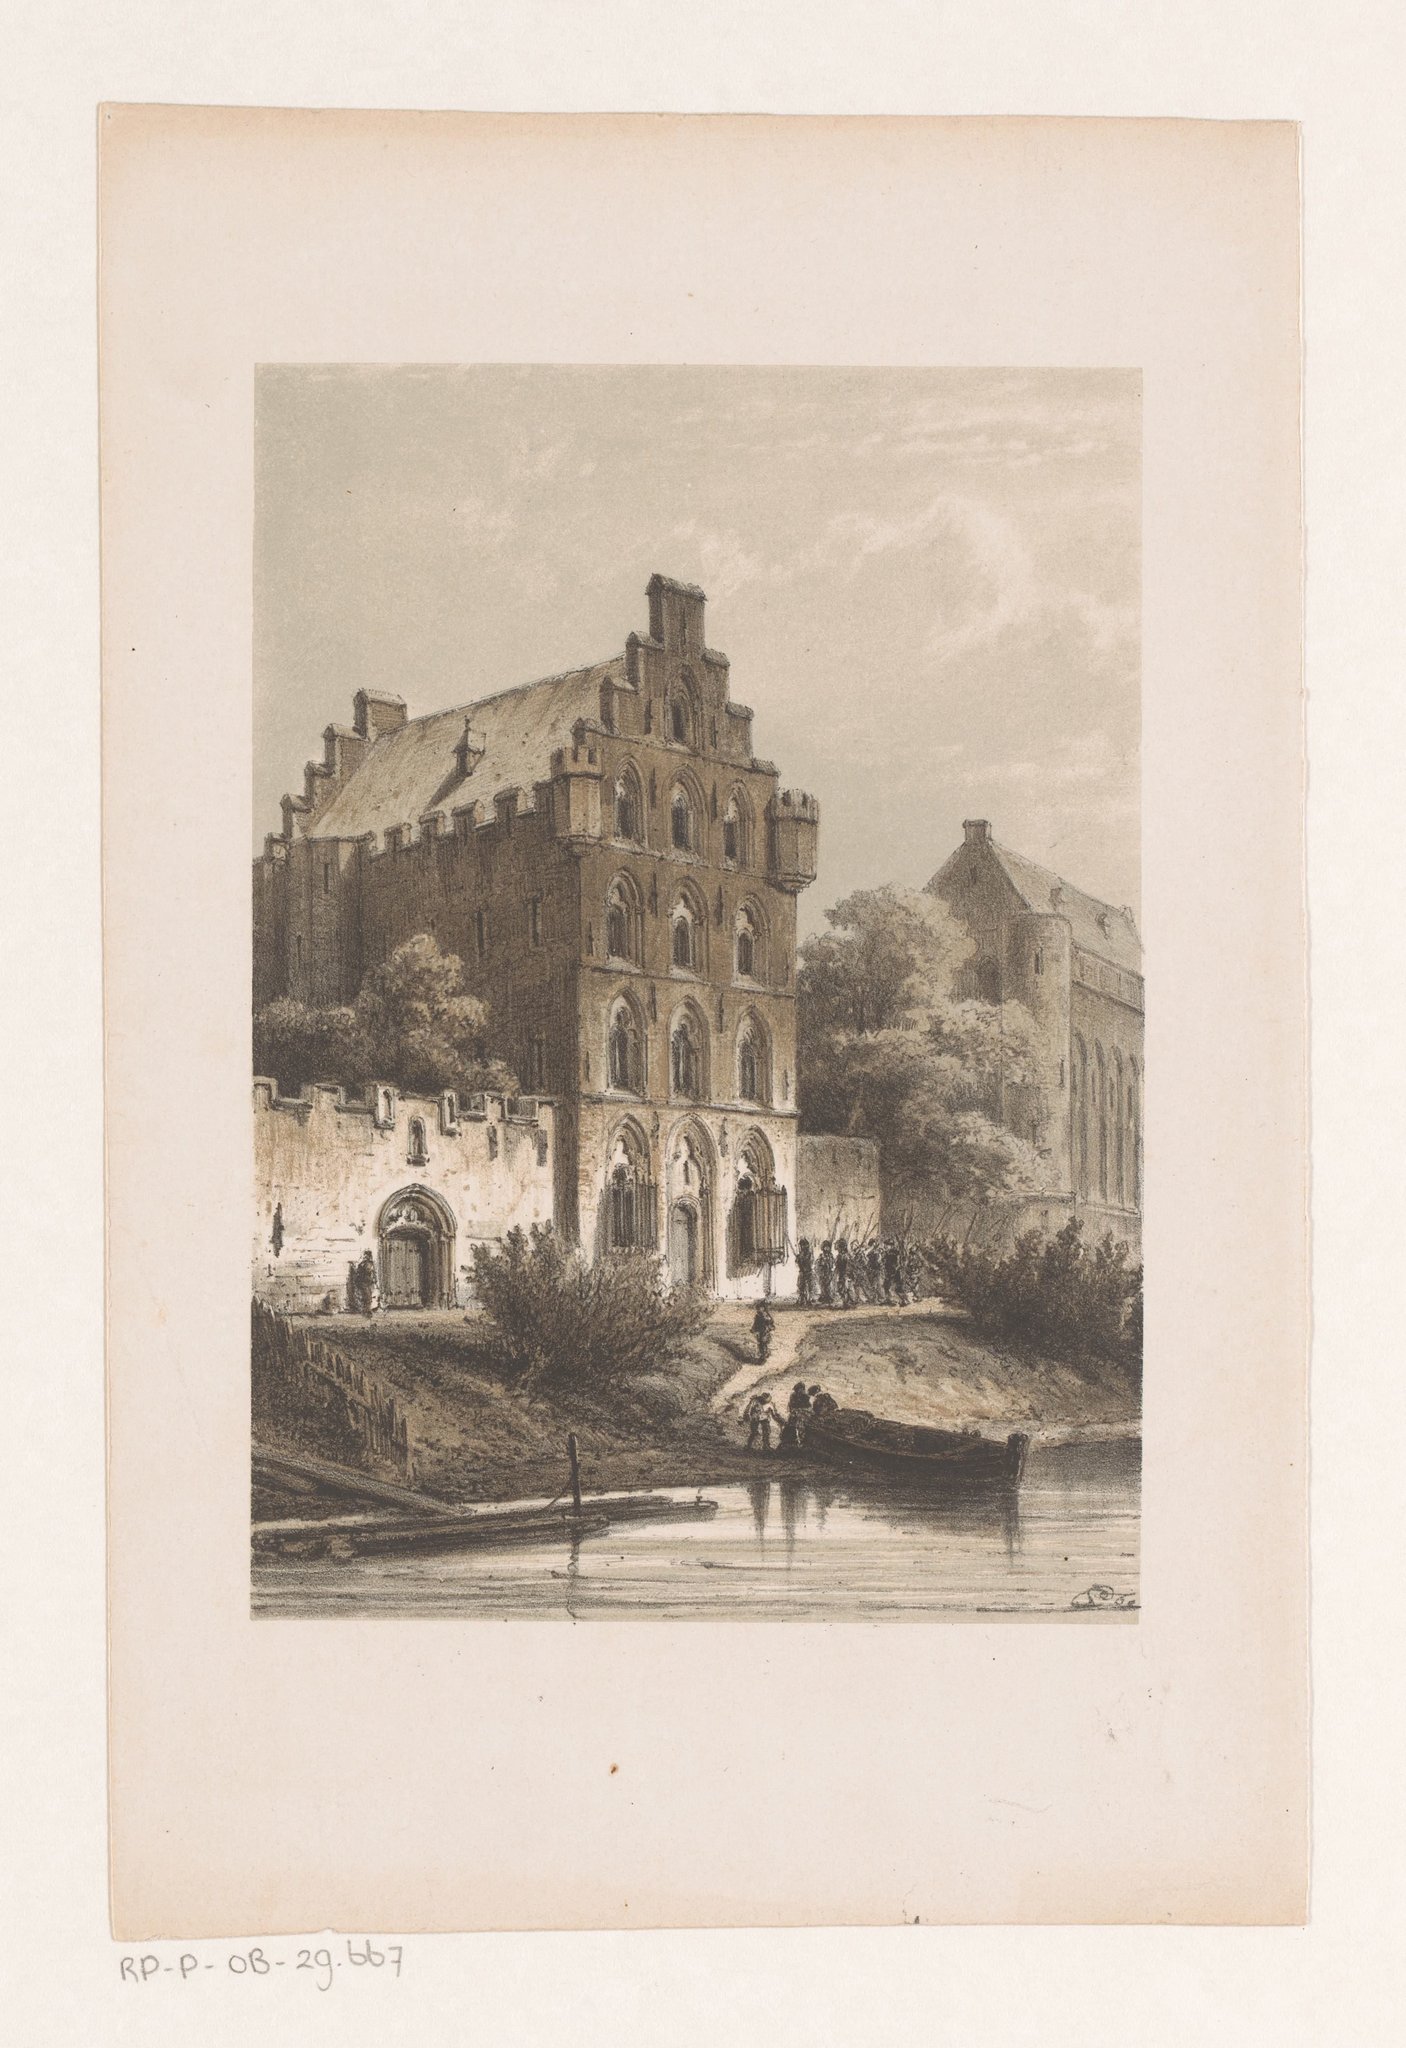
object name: print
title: Huizen langs het water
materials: paper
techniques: tone lithography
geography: haarlem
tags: landscapes with waters, waterscapes, seascapes (in the temperate zone), housing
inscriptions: collector's mark: Lugt 2228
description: Proefdruk voor prent uit: Hofdijk, W.J. Ons voorgeslacht. Haarlem: Kruseman, Arie Cornelis, 1862.